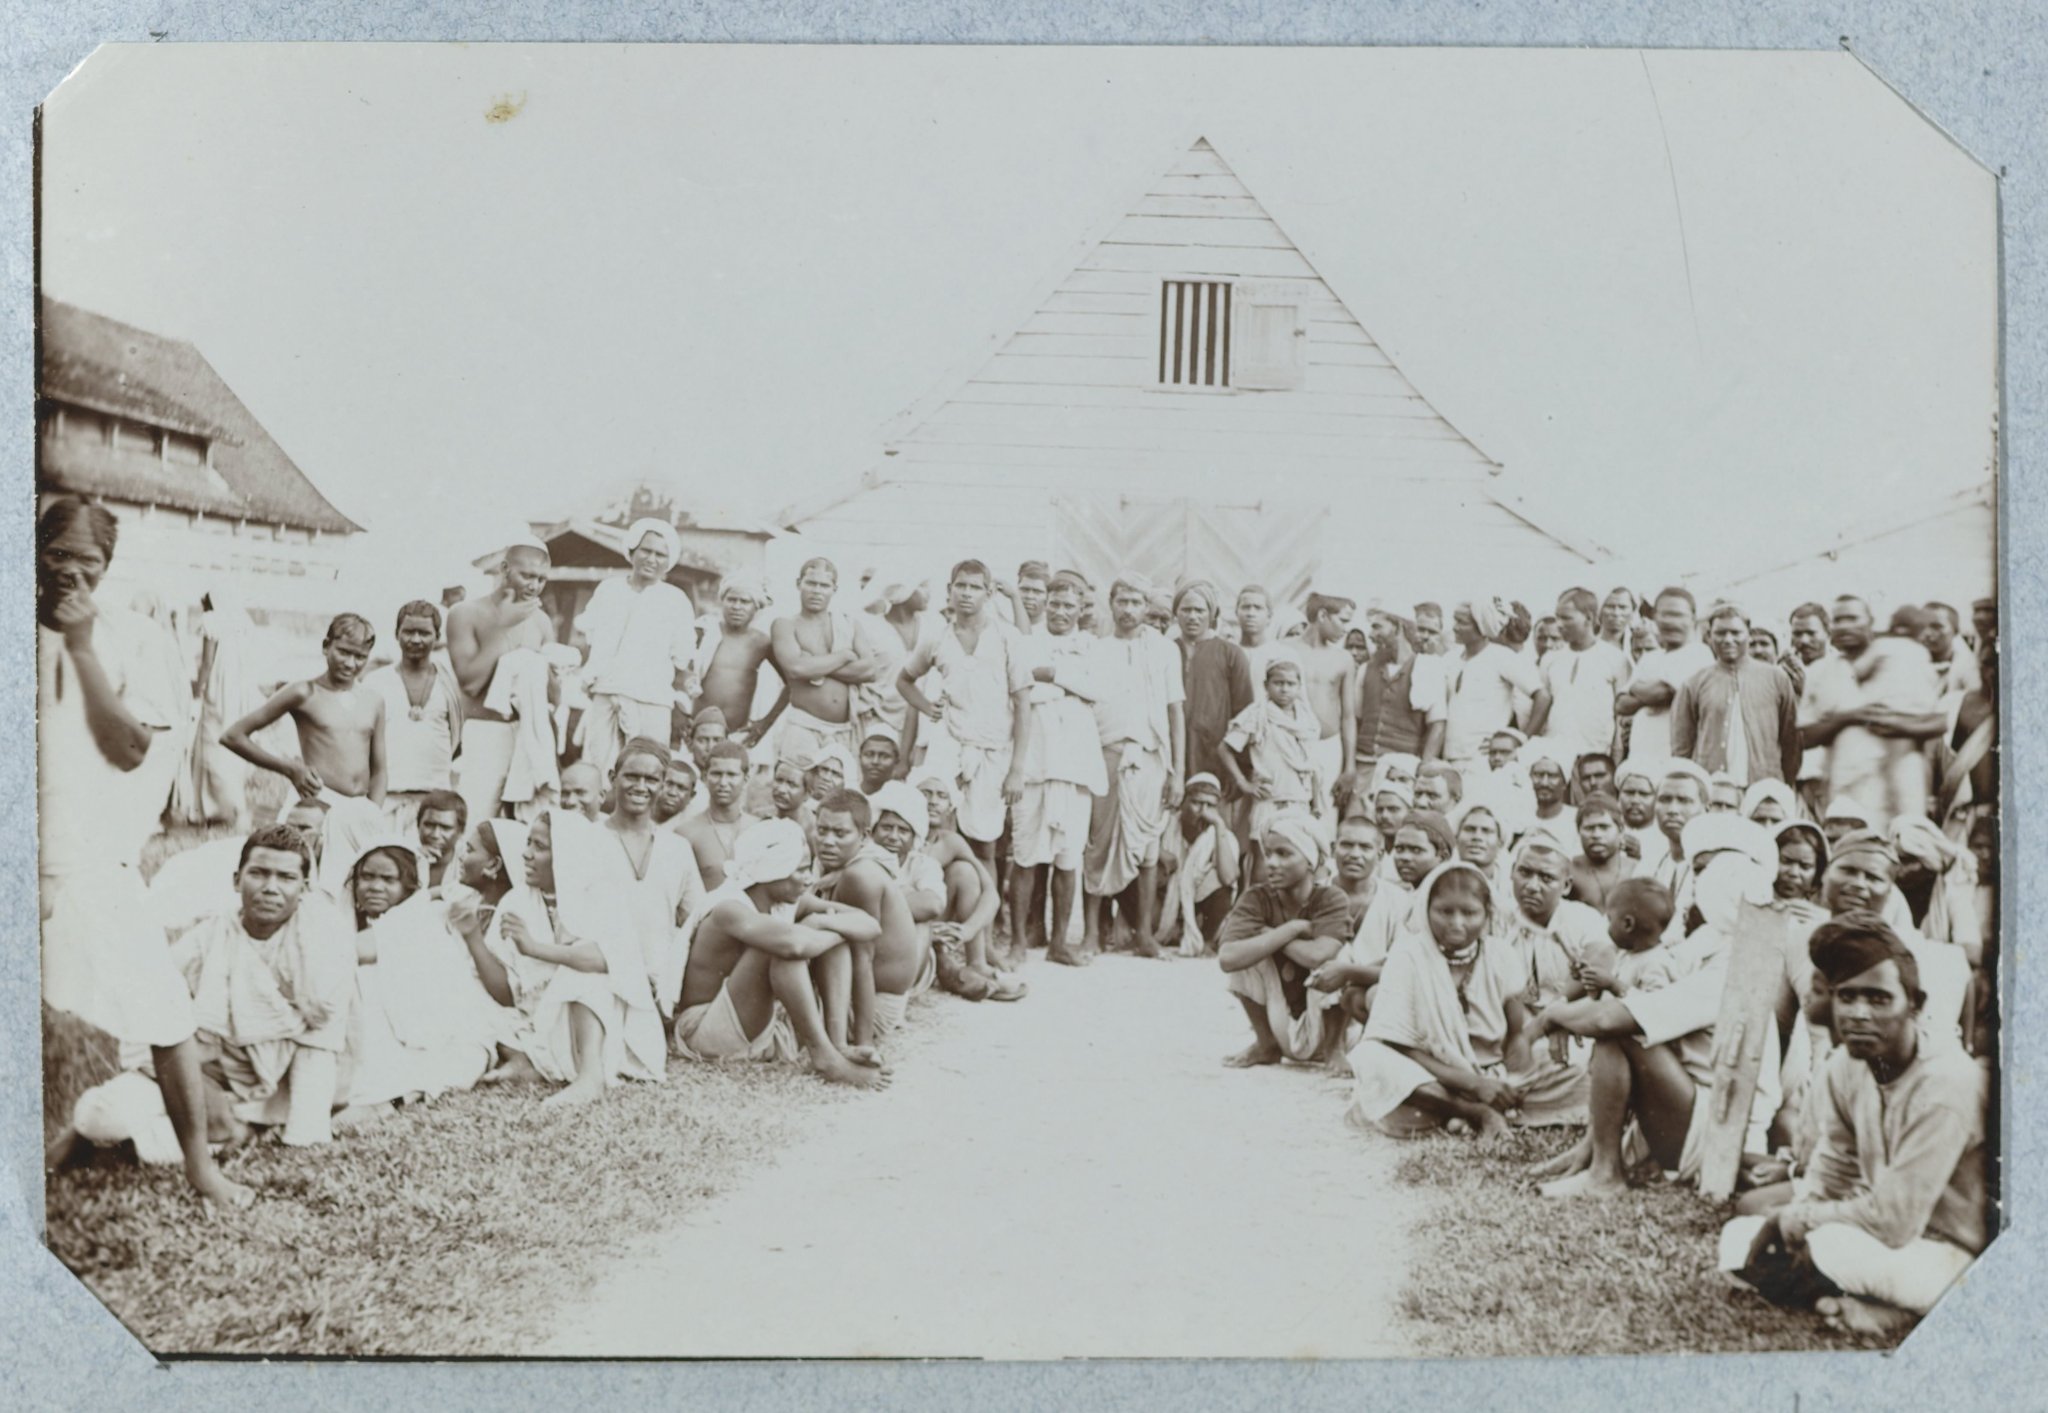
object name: photograph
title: Indentured Labourers in the Depot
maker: théodore van lelyveld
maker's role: painter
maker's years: 1867-1954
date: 1895-1898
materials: photographic support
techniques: collodion silver print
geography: suriname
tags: migrants, working class, labourers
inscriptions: inscription: ‘Br. Indiërs in het dépôt voor immigranten’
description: While most of the migrants are Hindu, there are the occasional Muslims and Christians as well. All castes (classes) are represented, however members of the low caste are in the majority. On the full ships, distinctions become less strict and lasting friendships develop between the men (Jehaji bais: friendship between brothers). Some find a bride on board, whom they marry upon reaching their destination.